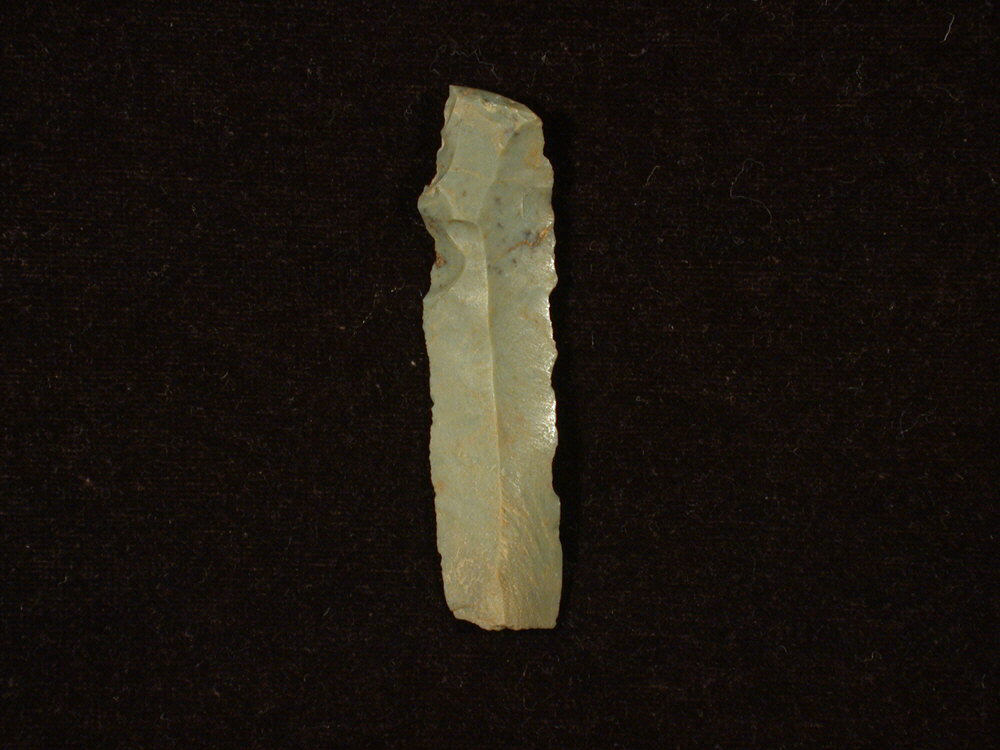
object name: knife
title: Blade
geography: iran